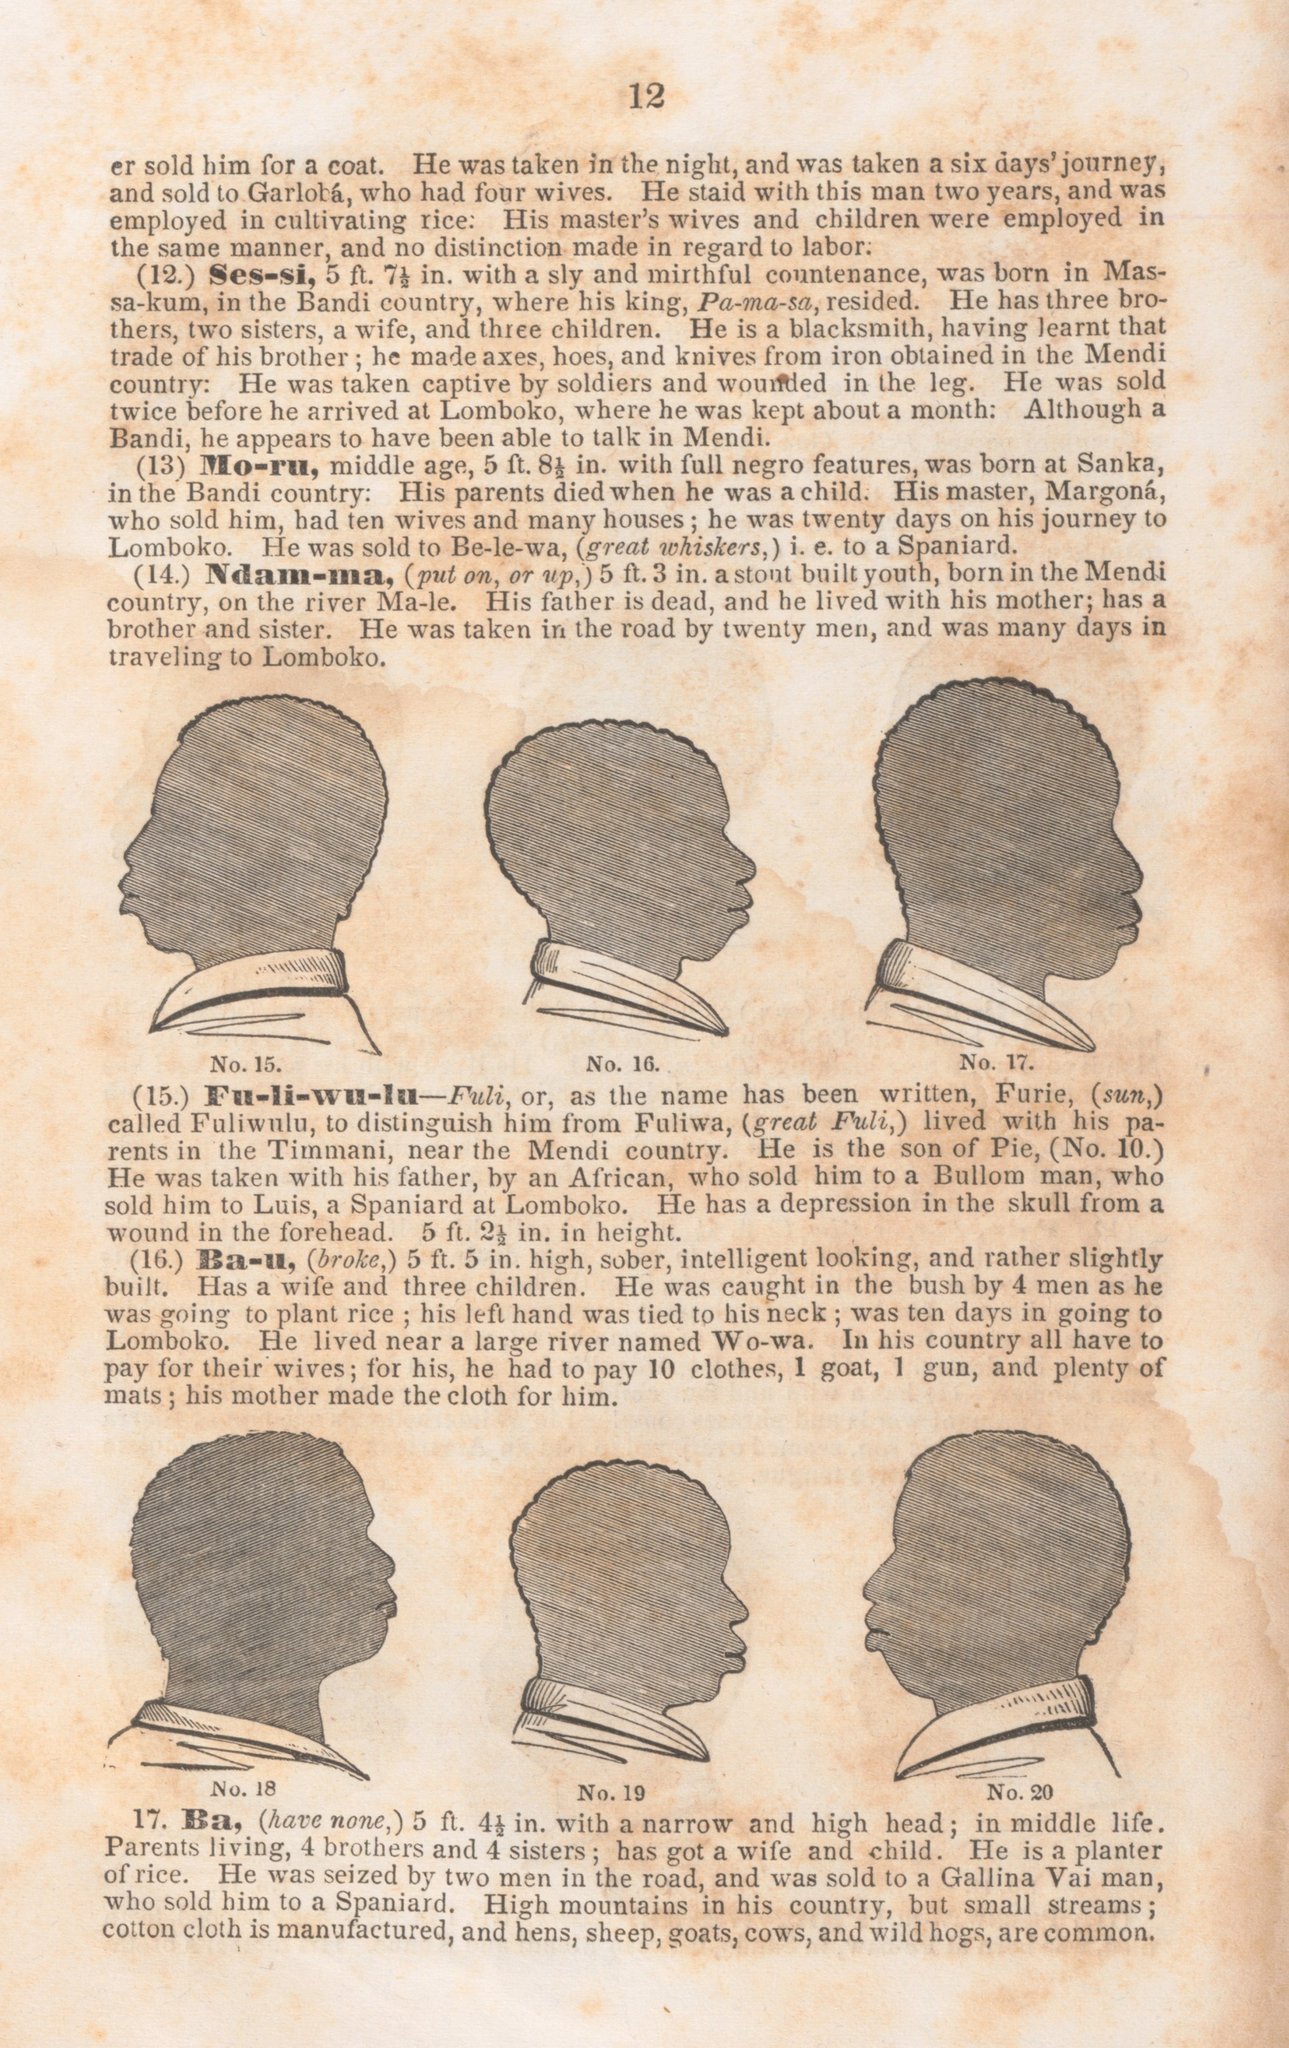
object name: book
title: A History of the Amistad Captives: Being a Circumstantial Account of the Capture of the Spanish Schooner Amistad, by the Africans on Board; Their Voyage, and Capture near Long Island, New York; with Biographical Sketches of Each of the Surviving Africans.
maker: john warner barber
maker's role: illustrator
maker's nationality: american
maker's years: 1798-1885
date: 1840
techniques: hand coloring, letterpress, engraving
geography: new haven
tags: slavery